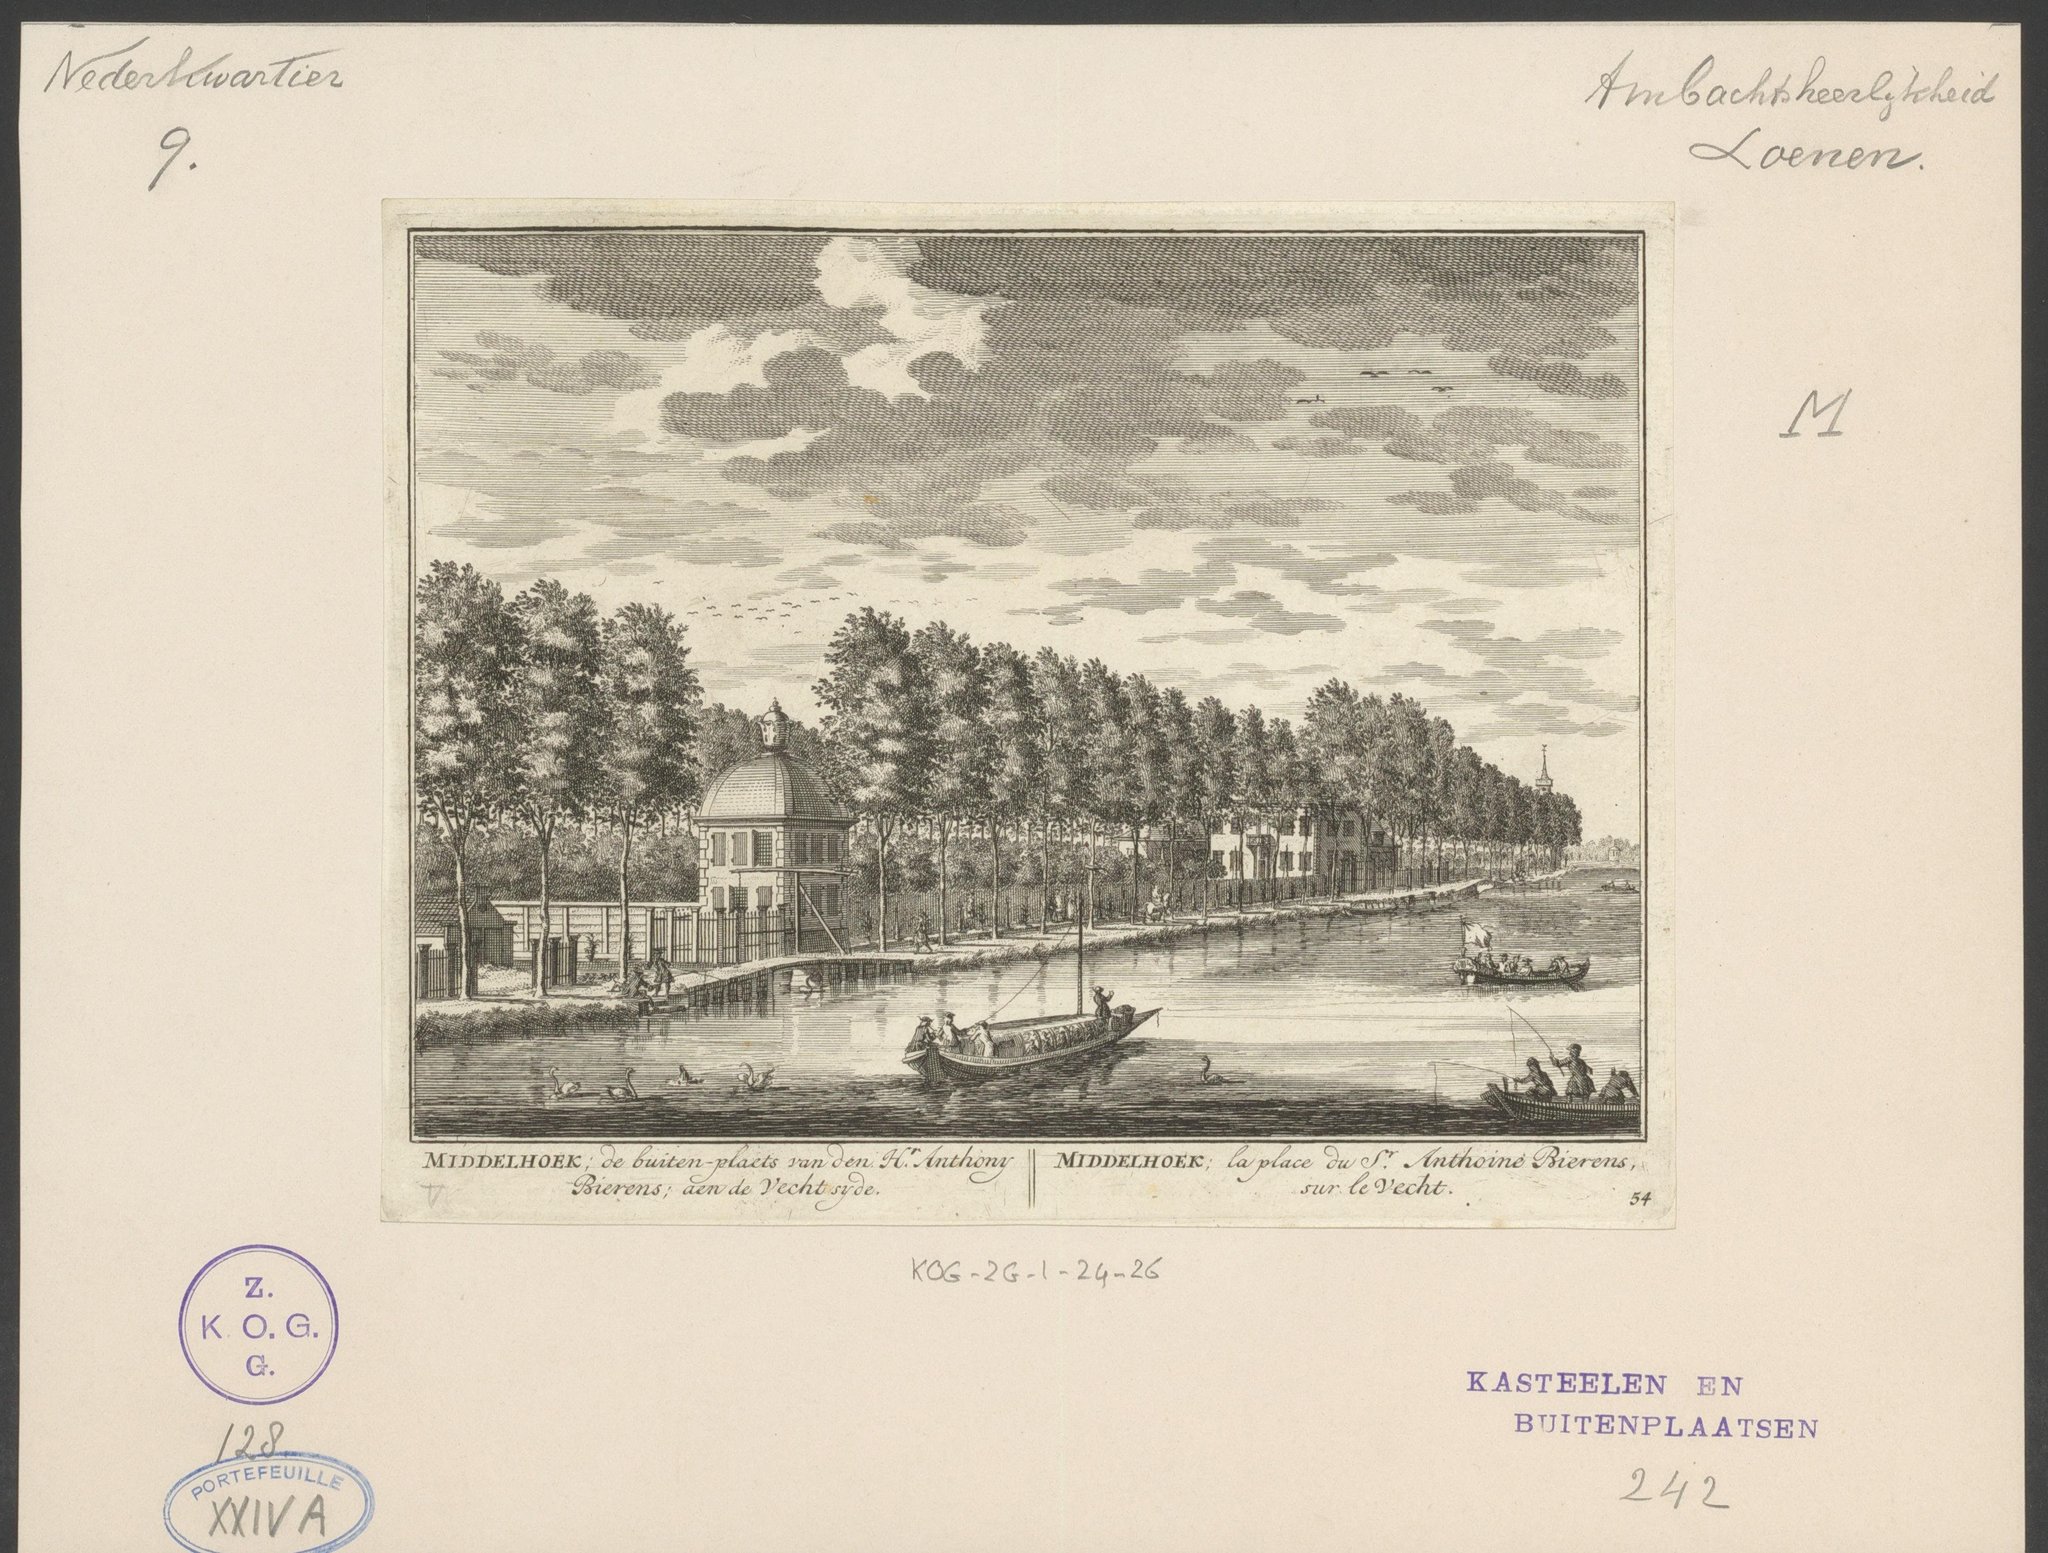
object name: book illustration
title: Gezicht op de buitenplaats Middenhoek aan de Vecht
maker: daniël stopendaal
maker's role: print maker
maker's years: 1672-1726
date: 1790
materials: paper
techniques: engraving, etching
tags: river (+ landscape with figures, staffage), country-house, vecht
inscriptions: collector's mark: Lugt 1641, stamp, stamp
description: Prent mogelijk uit: Leth, Andries de. De zegepraalende Vecht, vertoonende verscheidene gesichten van lustplaatsen, heeren huysen en dorpen, beginnende van Uitrecht en met Muyden besluytende (...). Amsterdam: Weduwe Nicolaus Visscher, 1719. Of uit: Brouërius van Nidek, Matthaeus. De Vechtstroom, van Utrecht tot Muiden (...). Amsterdam: H. Gartman, W. Vermandel en J.W. Smit, 1790.